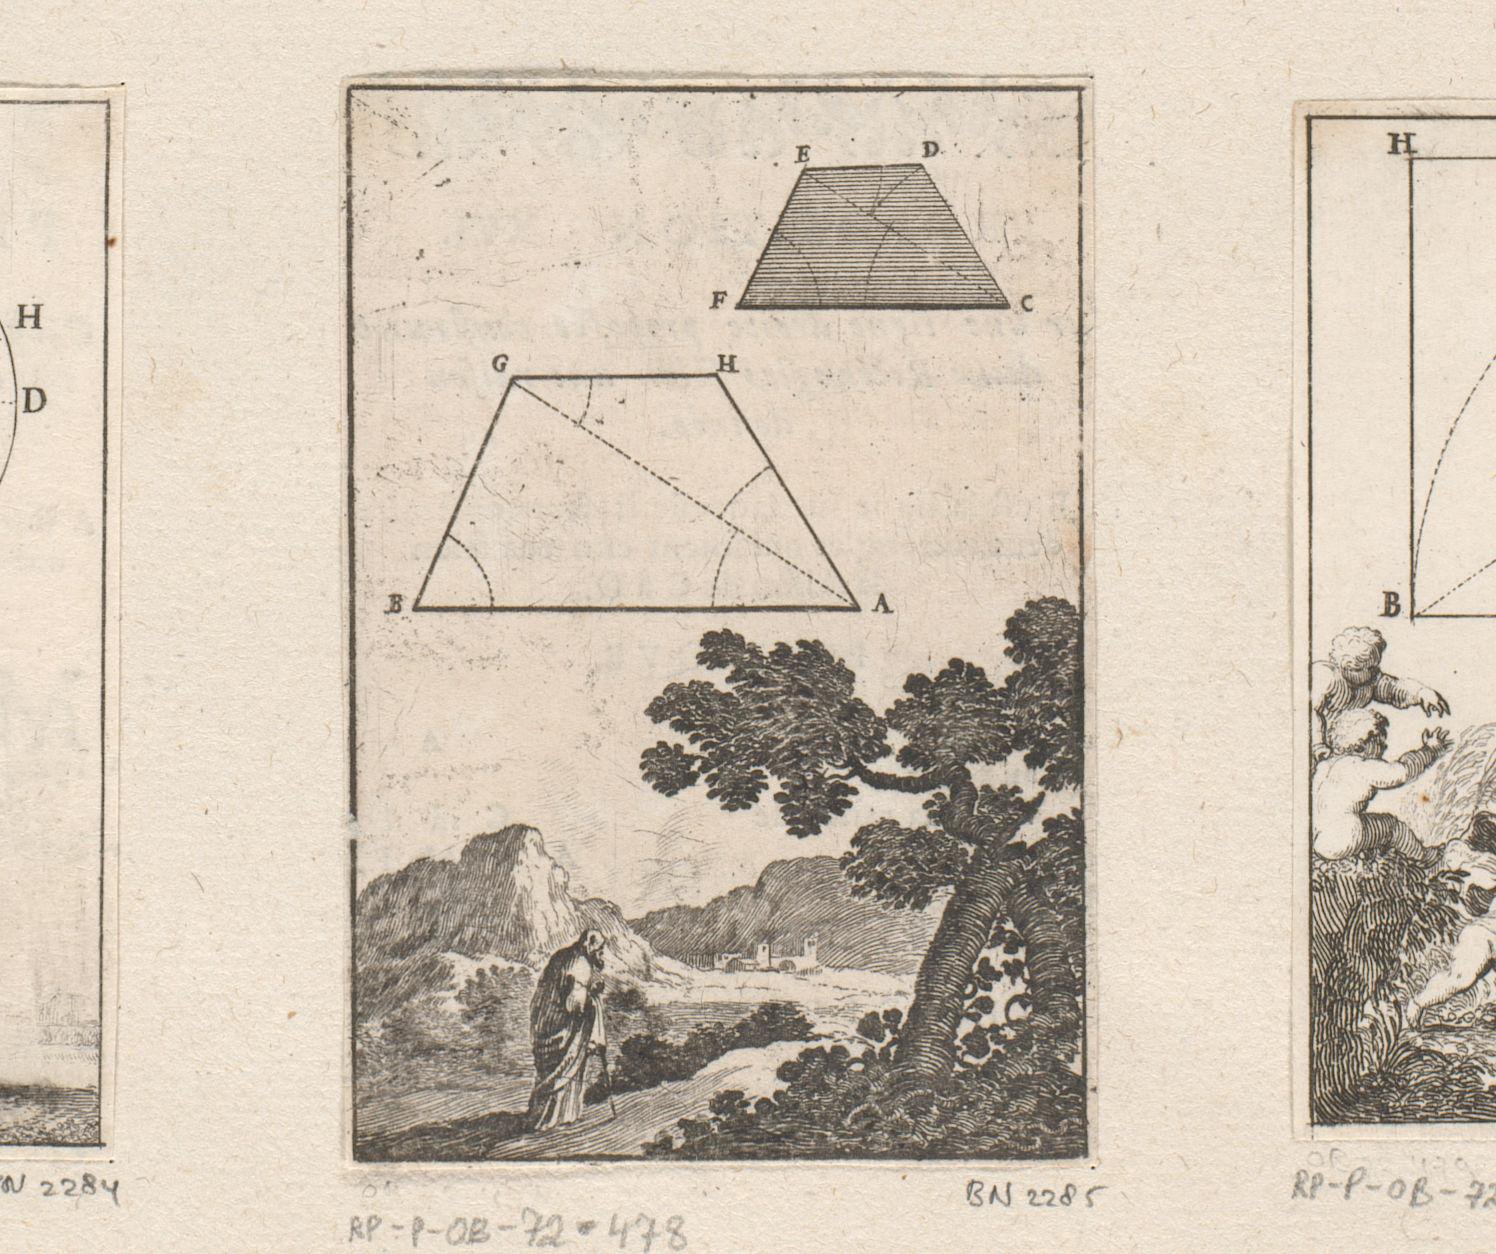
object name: print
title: Constructie van een rechthoek met onderaan een wandelaar in een landschap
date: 1669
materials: paper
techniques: etching, letterpress printing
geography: paris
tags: walking, hiking (recreation), planimetry, geometry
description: Prent uit: Pratique de la géometrie, sur le papier et sur le terrain. Avec un nouvel ordre et une méthode particulière. Parijs: Thomas Jolly, 1669.